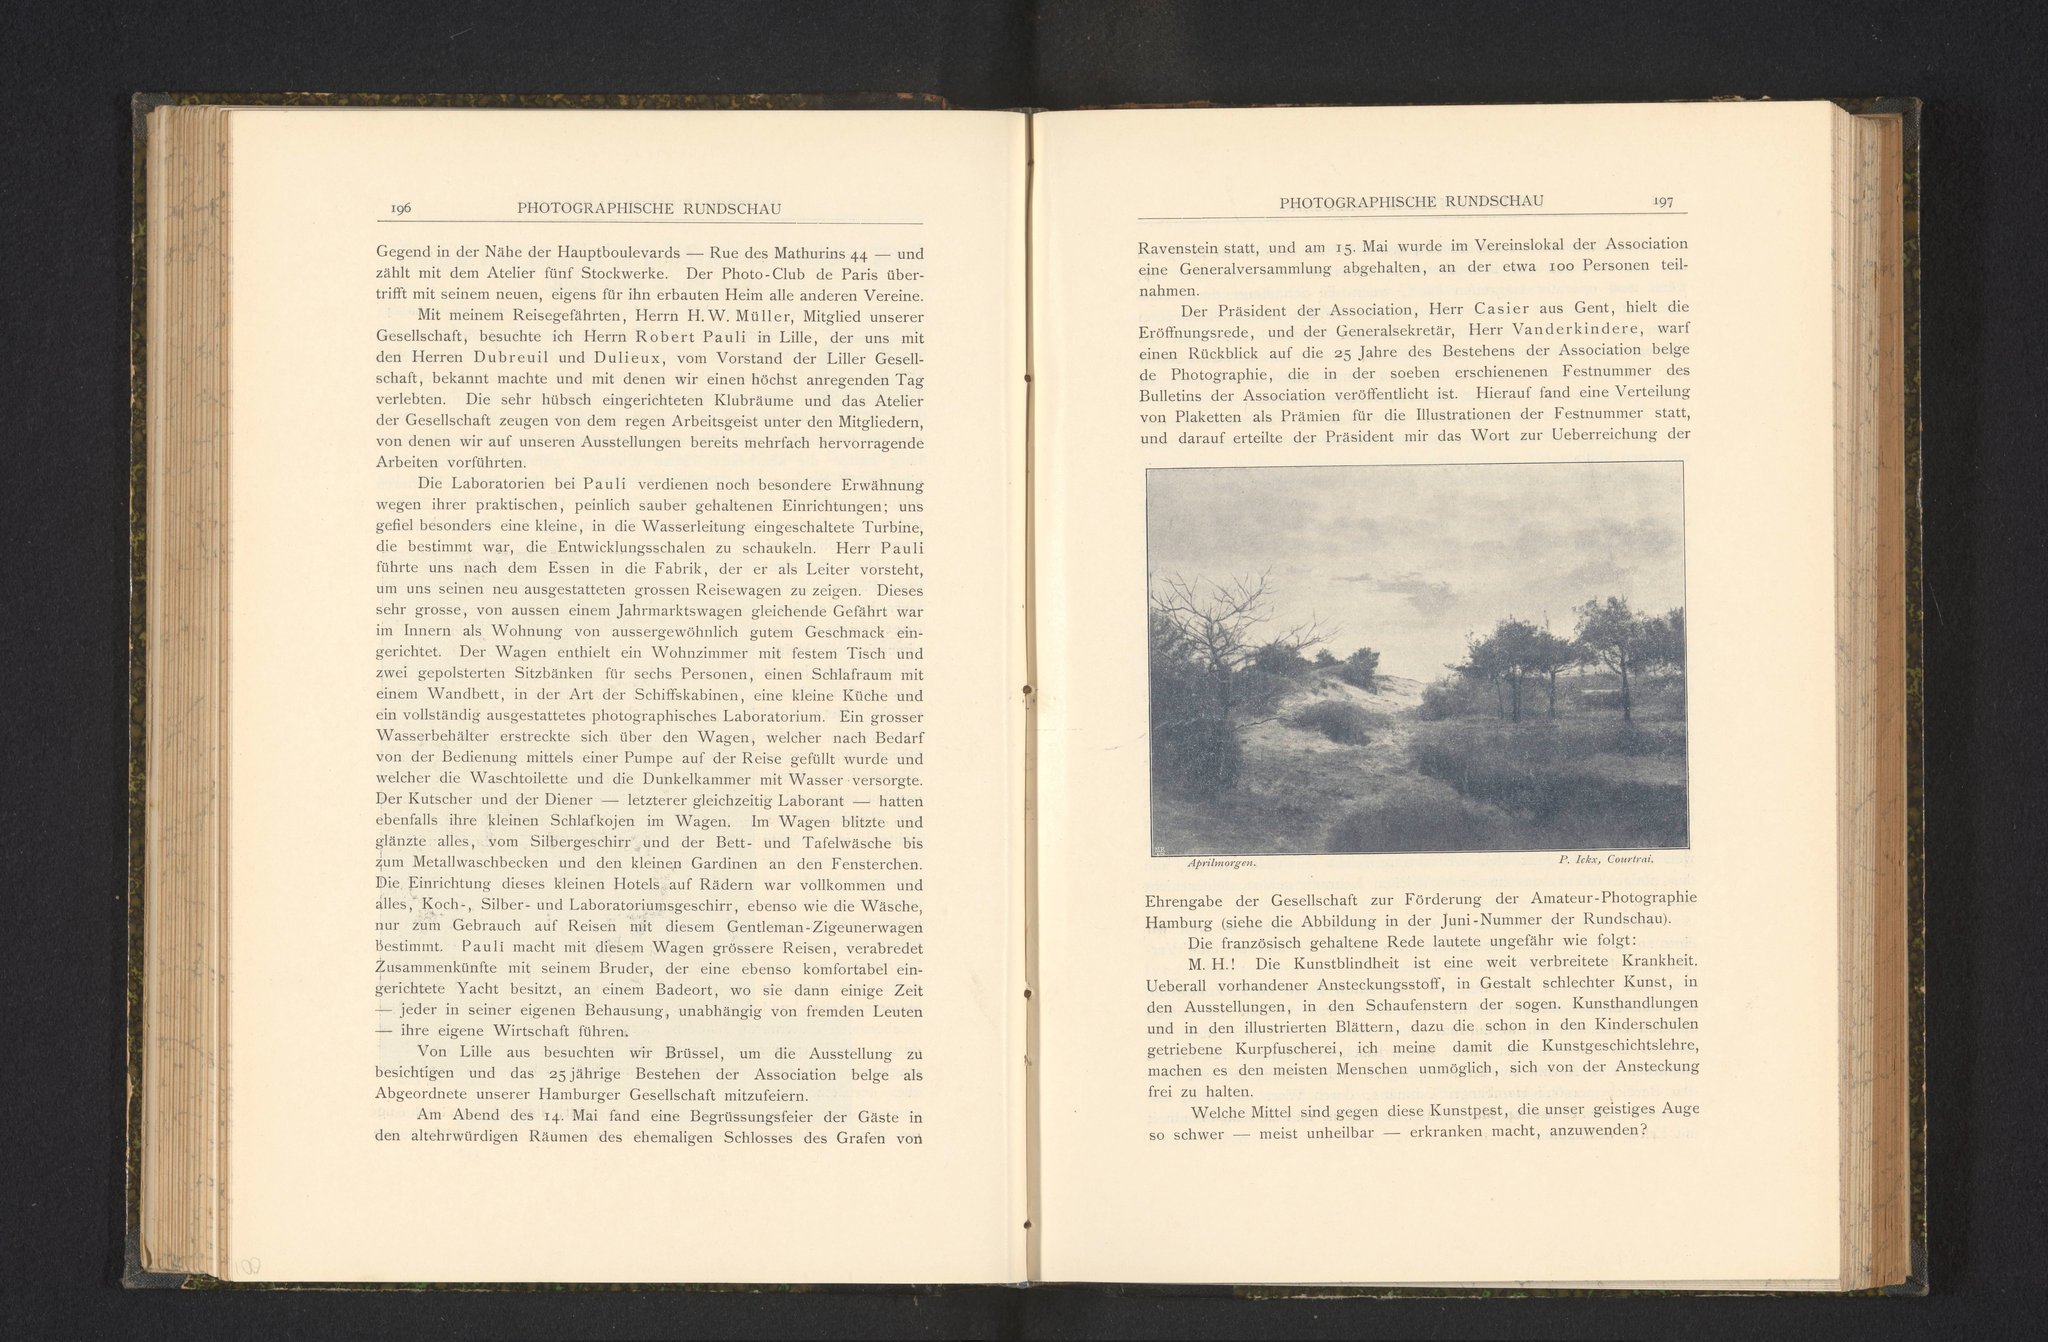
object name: photomechanical print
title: Duinlandschap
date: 1893-1898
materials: paper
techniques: autotype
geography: kortrijk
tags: dunes (sea not visible); in the dunes